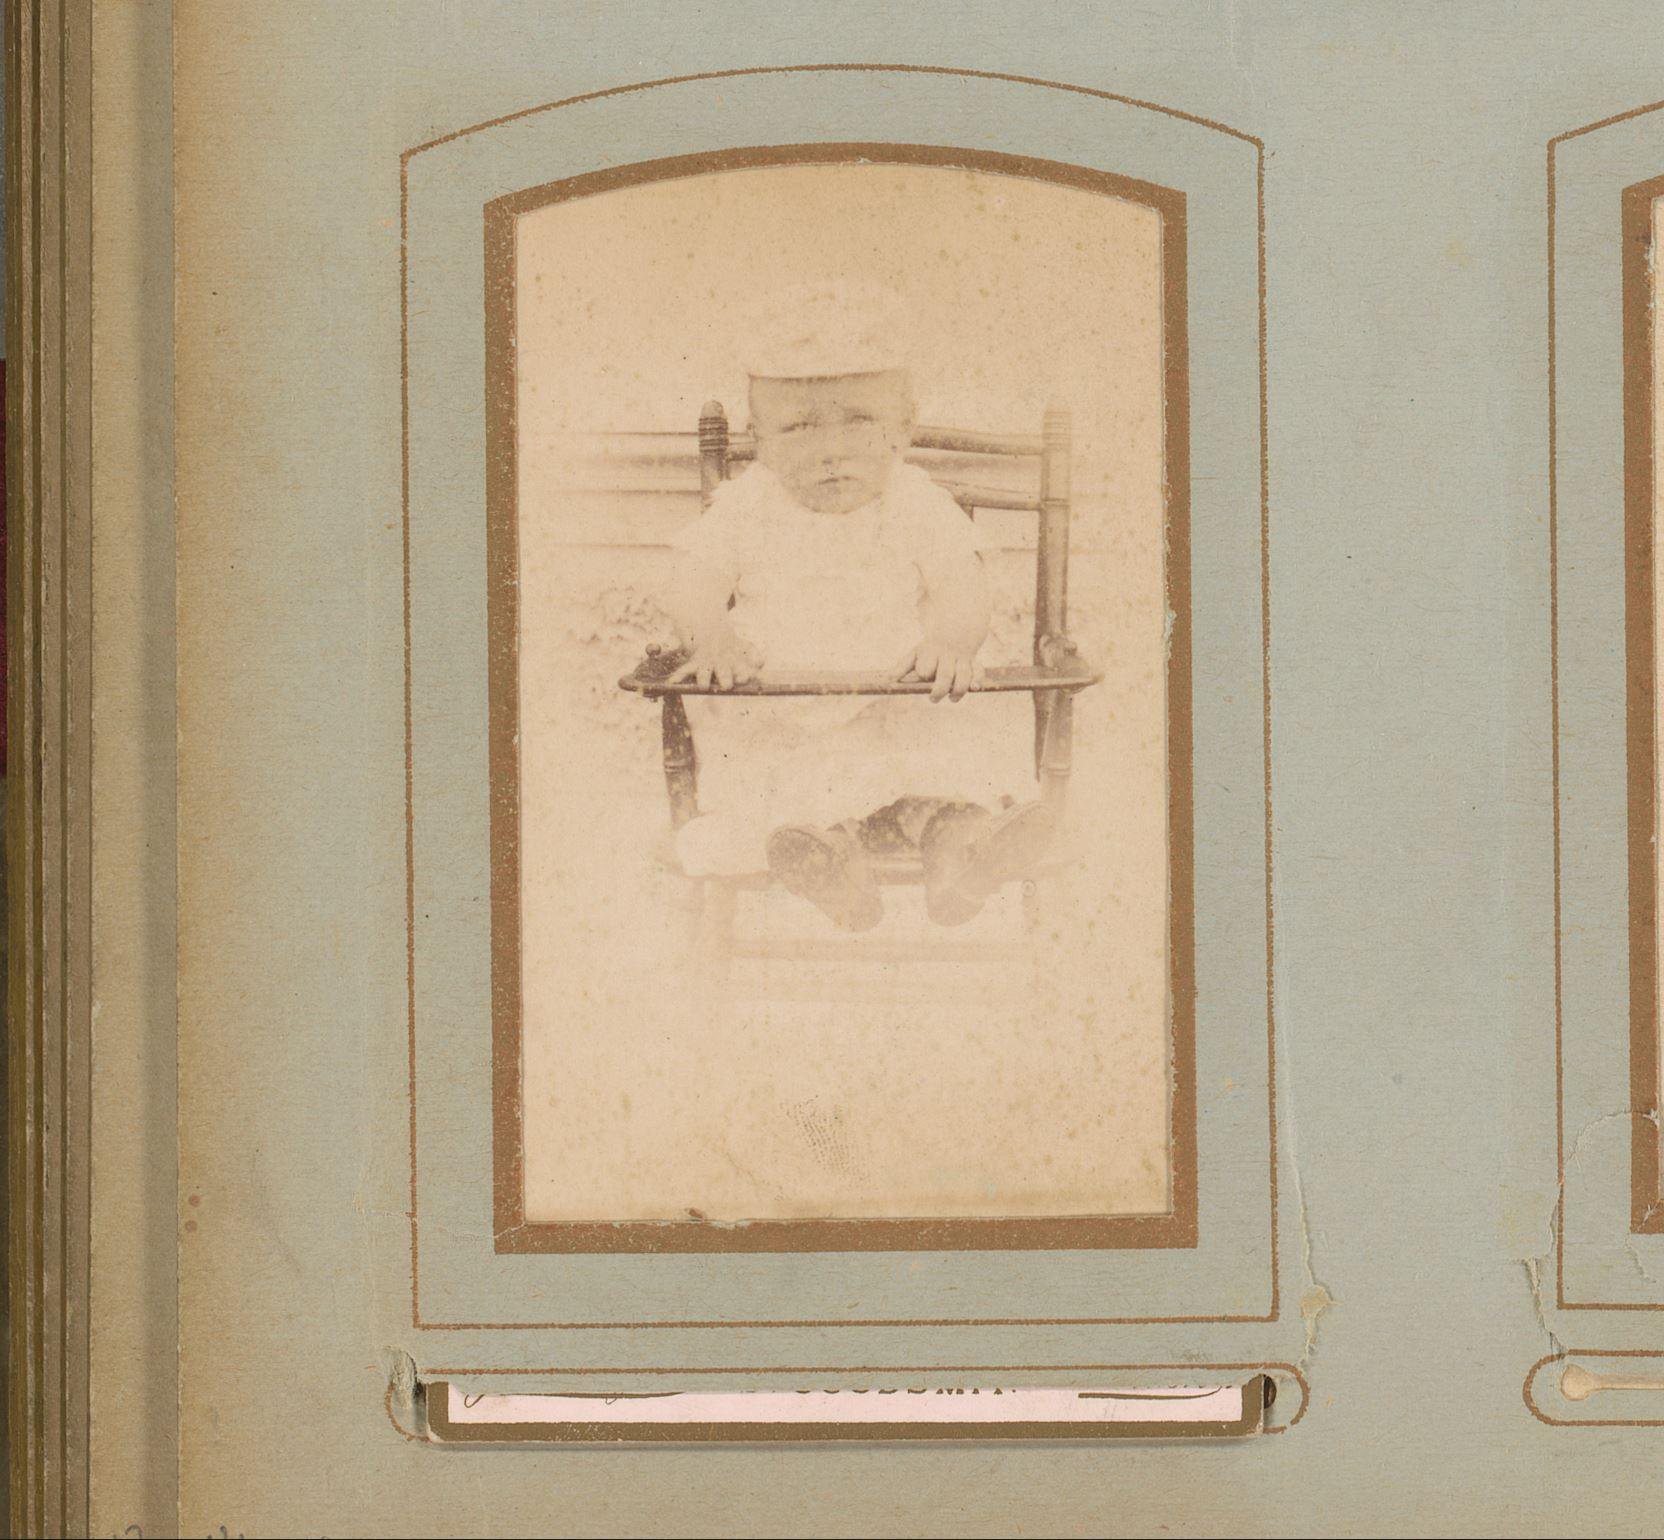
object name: carte de visite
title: Portret van een kind, zittend in een kinderstoel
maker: salomon goudsmit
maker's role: fotograaf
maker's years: 1864-1919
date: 1885-1895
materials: cardboard, photographic support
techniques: albumen print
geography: amsterdam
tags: child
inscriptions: inscription: ‘Photographisches Atelier/ S. Goudsmit/ Groningen/ Folkingestraat/ F231/ Assen/ Beilerstraat A77’